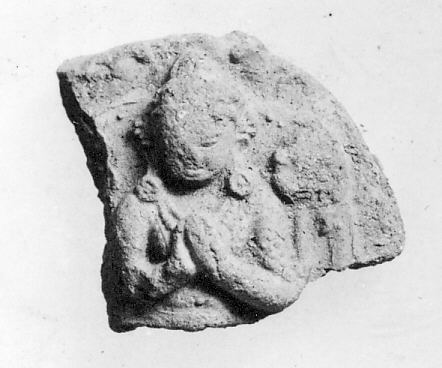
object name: plaque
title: Votive Plaque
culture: central asian or tibetan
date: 1401-1700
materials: clay